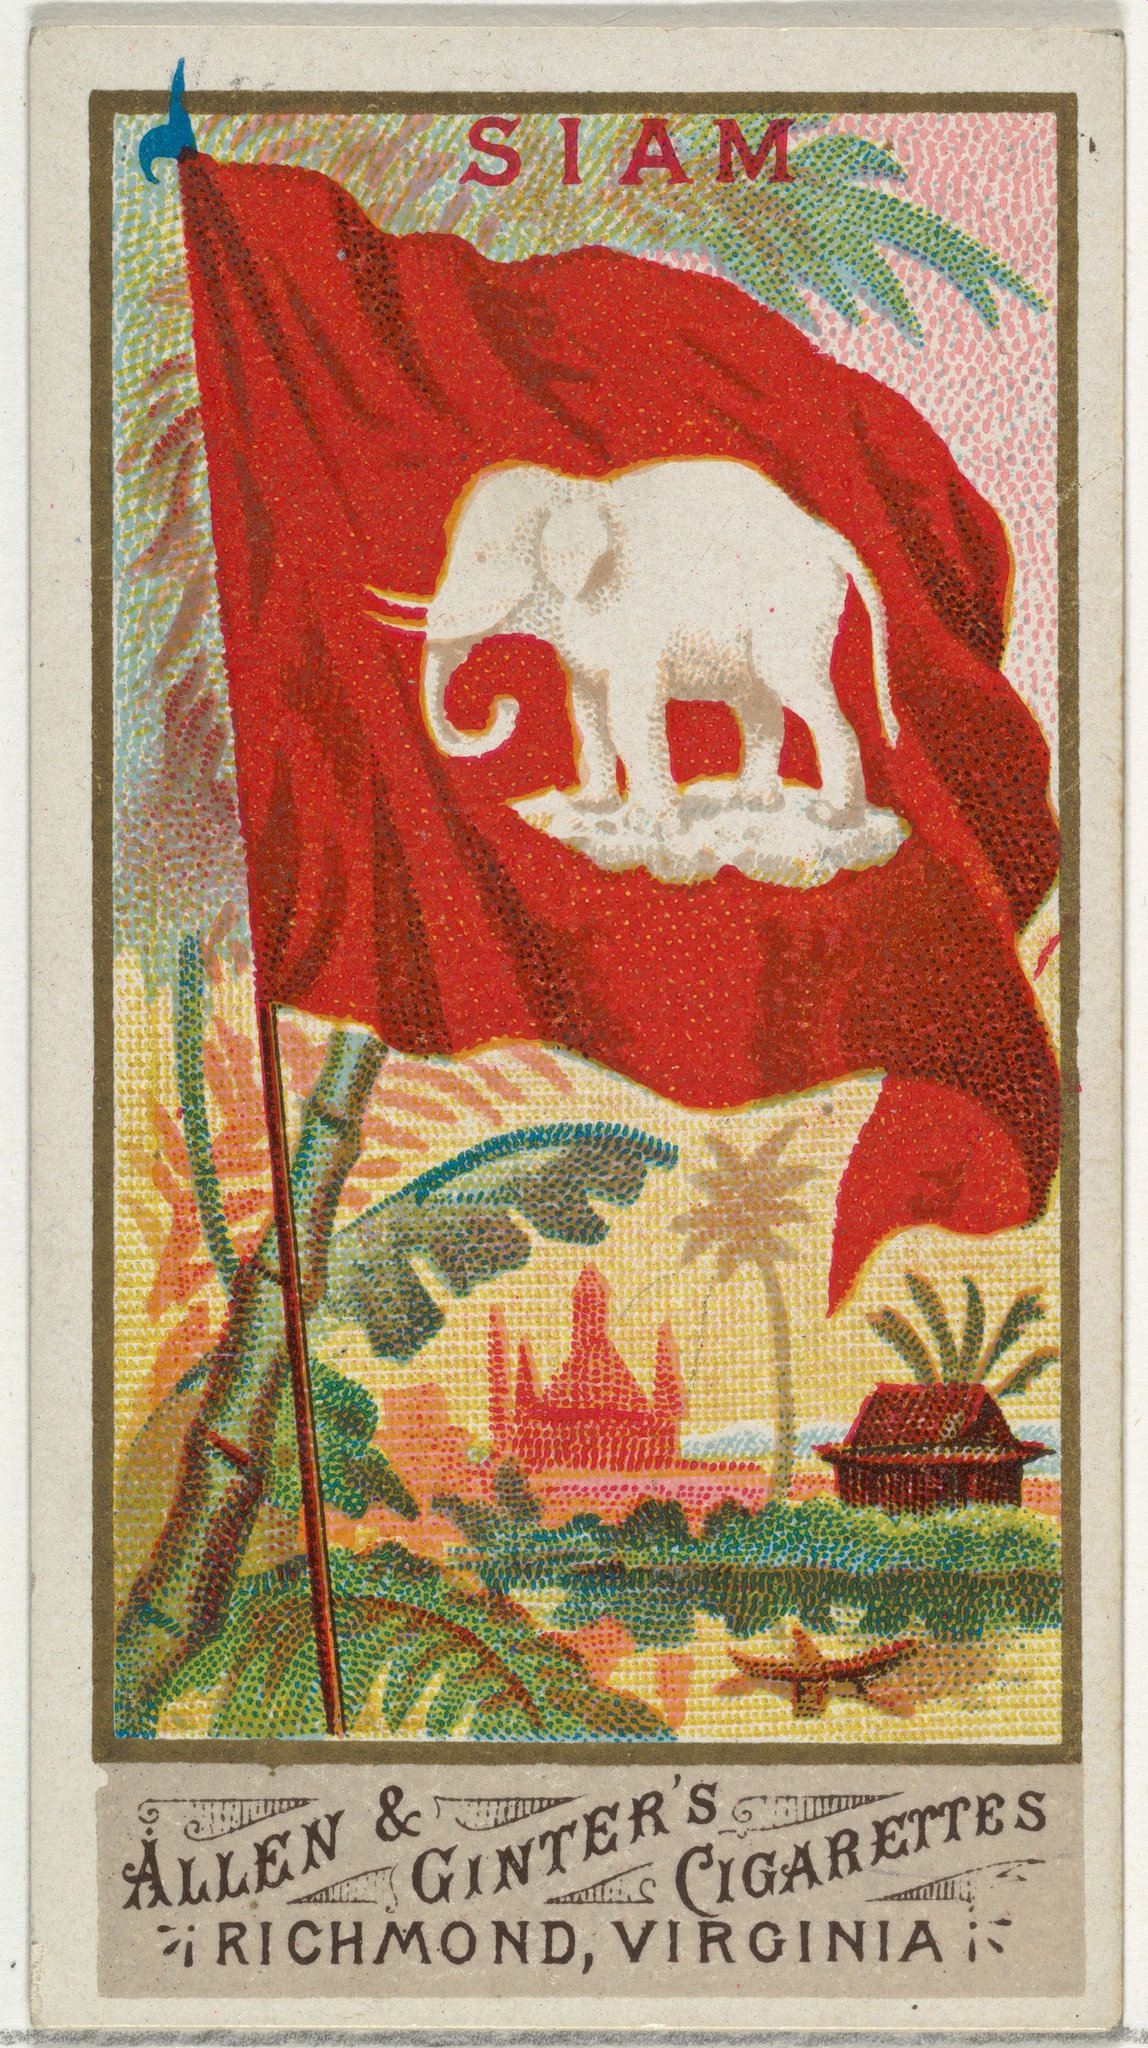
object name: print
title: Siam, from Flags of All Nations, Series 1 (N9) for Allen & Ginter Cigarettes Brands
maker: allen & ginter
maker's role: publisher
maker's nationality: american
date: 1887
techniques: color lithograph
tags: elephants,flags